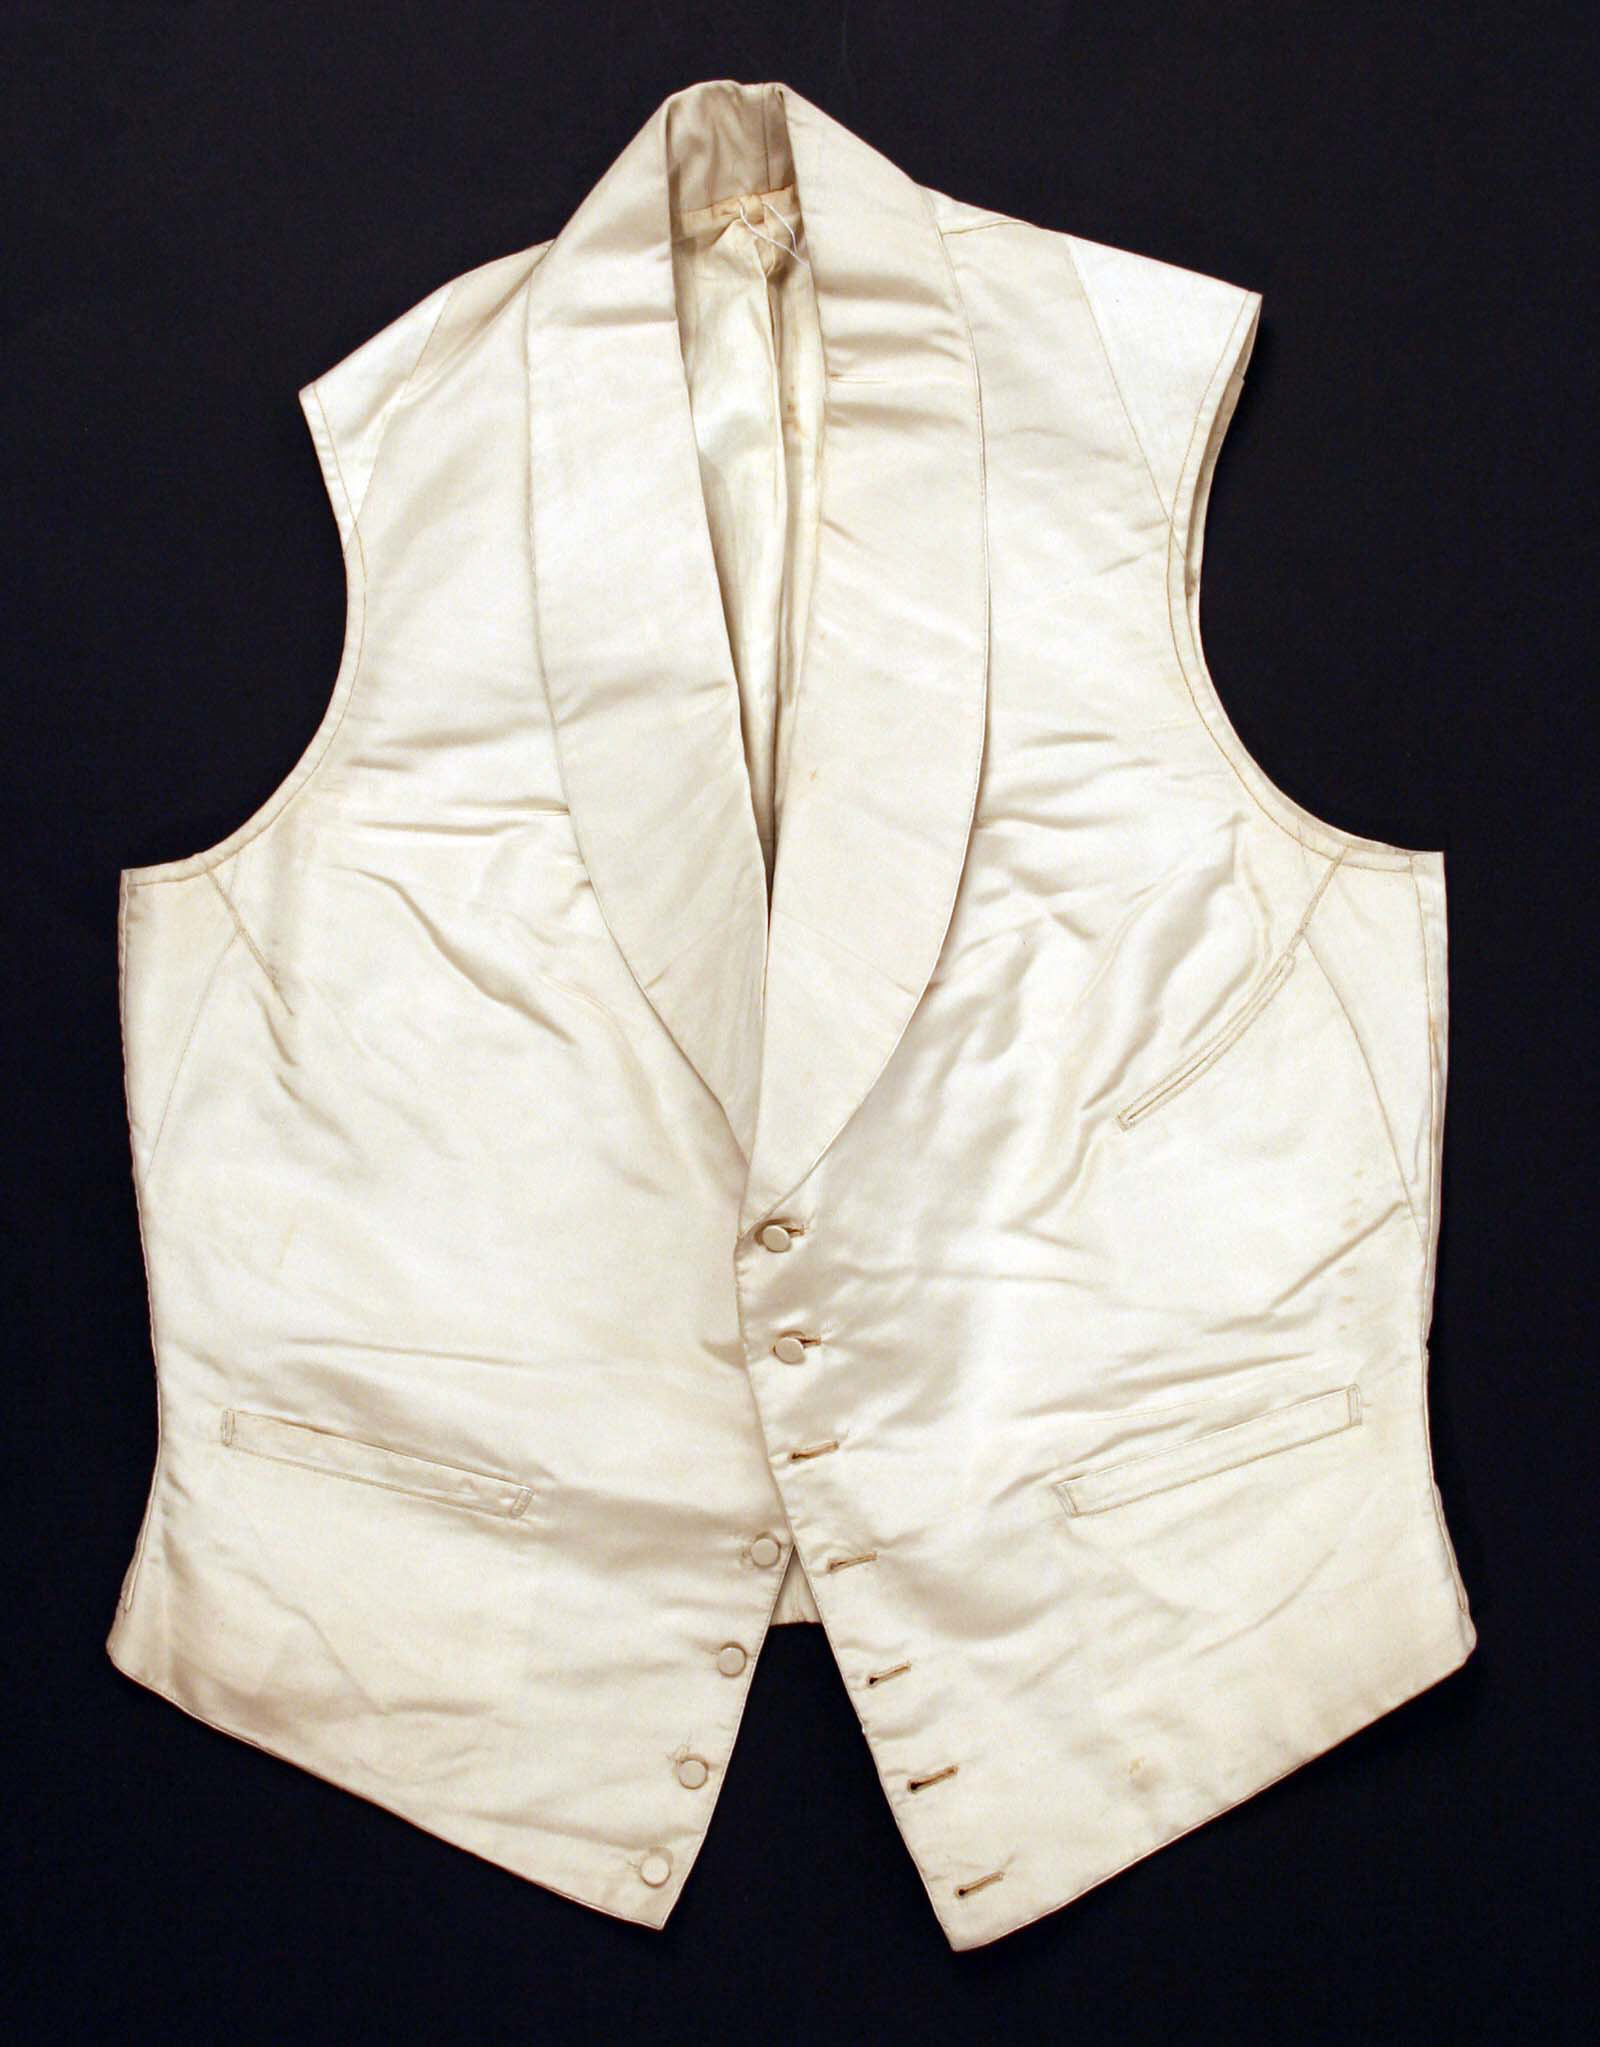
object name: waistcoat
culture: american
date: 1801-1900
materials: silk